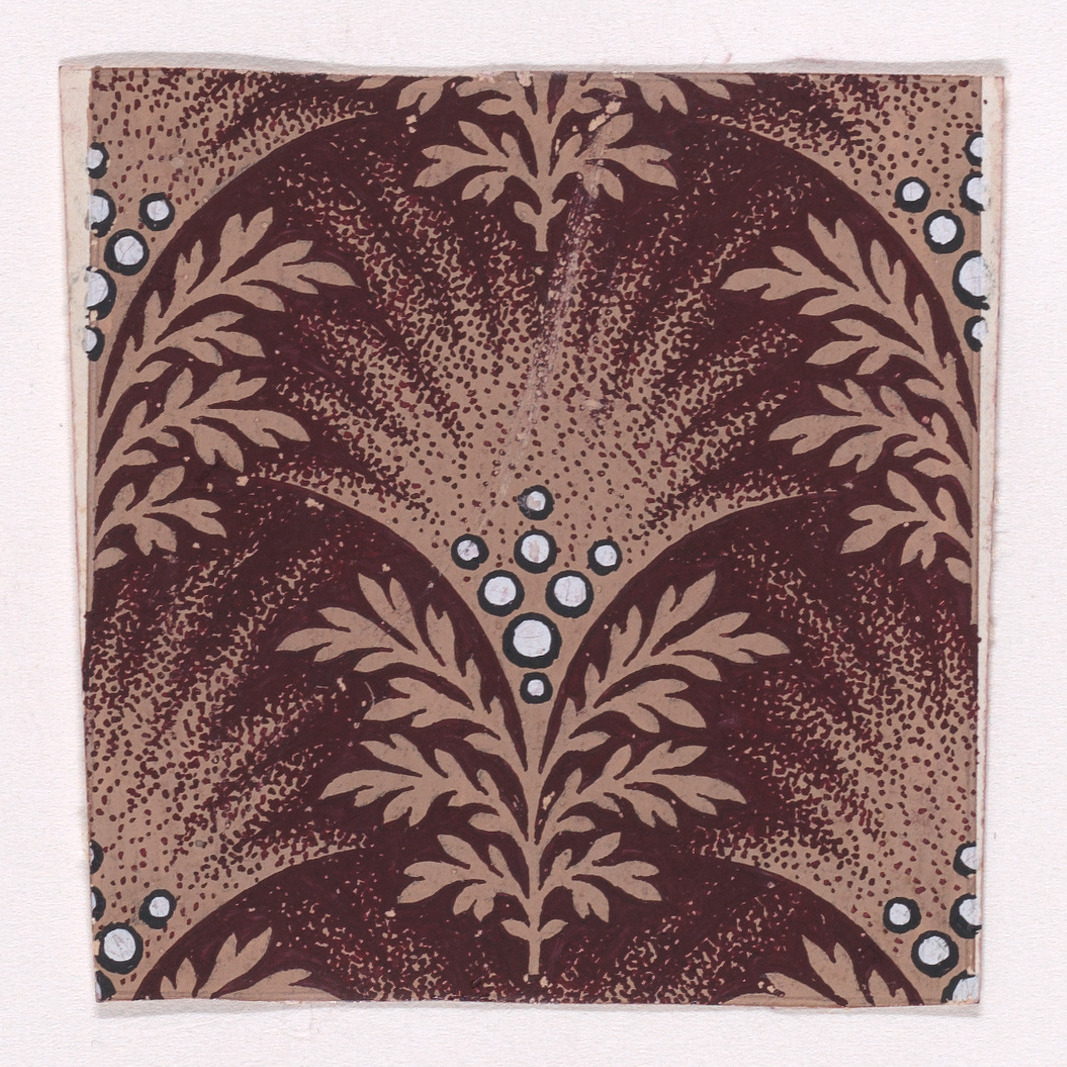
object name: drawing ornament architecture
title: Textile Design with Alternating Palmettes Decorated with Pearls Flanked by Bundles of Leaves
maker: anonymous, alsatian, 19th century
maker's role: artist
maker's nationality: alsatian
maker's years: 1800-1900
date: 1840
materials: gouache